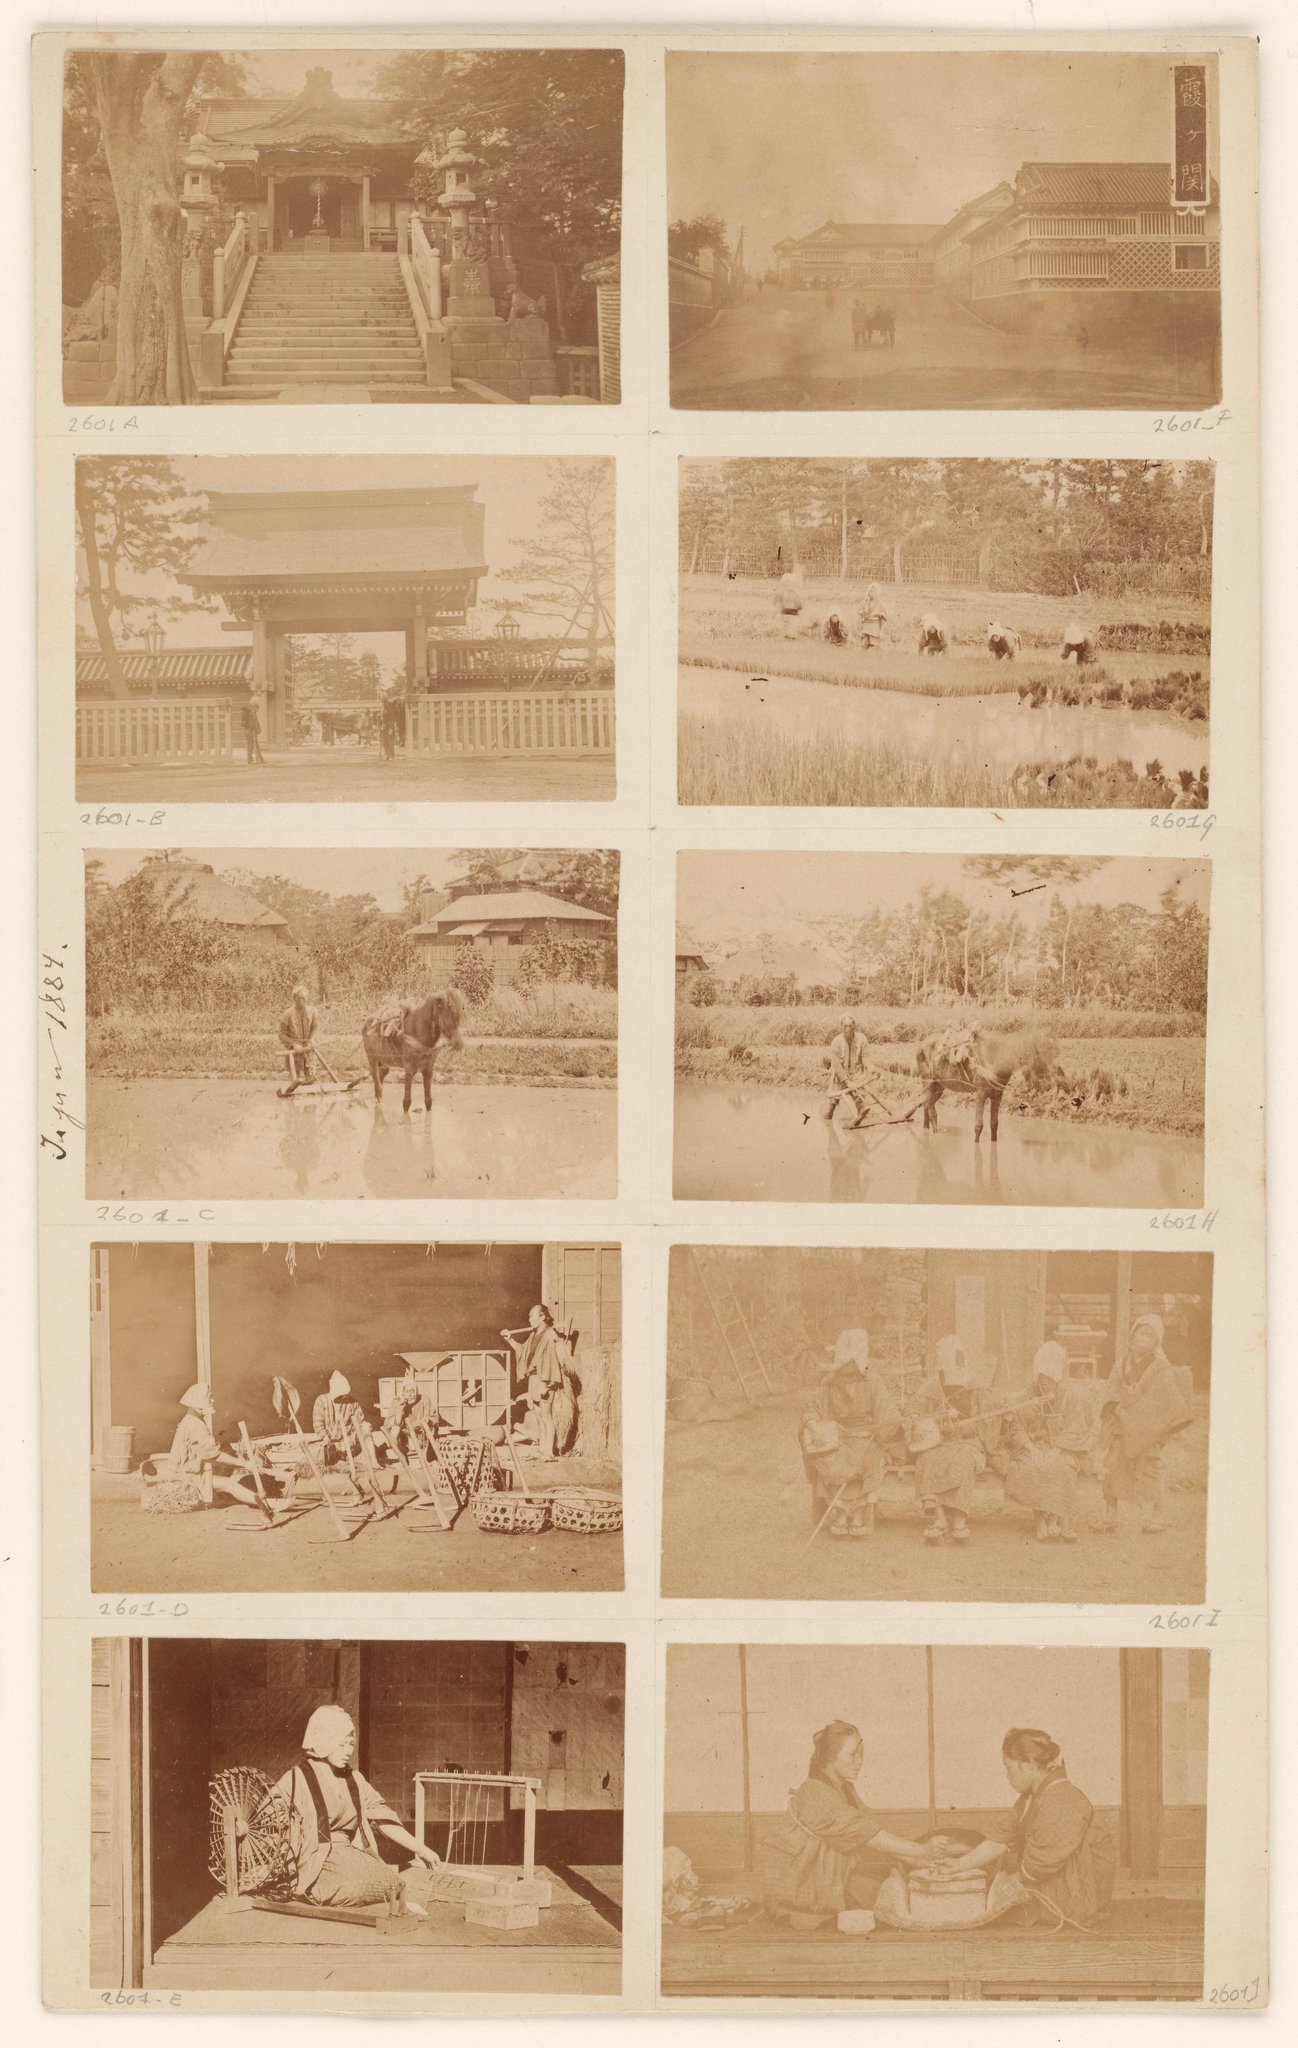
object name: photograph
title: Gezicht op een tempel in Japan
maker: Anonymous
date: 1884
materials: cardboard, paper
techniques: albumen print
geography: japan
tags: temple, shrine ~ shinto, japan